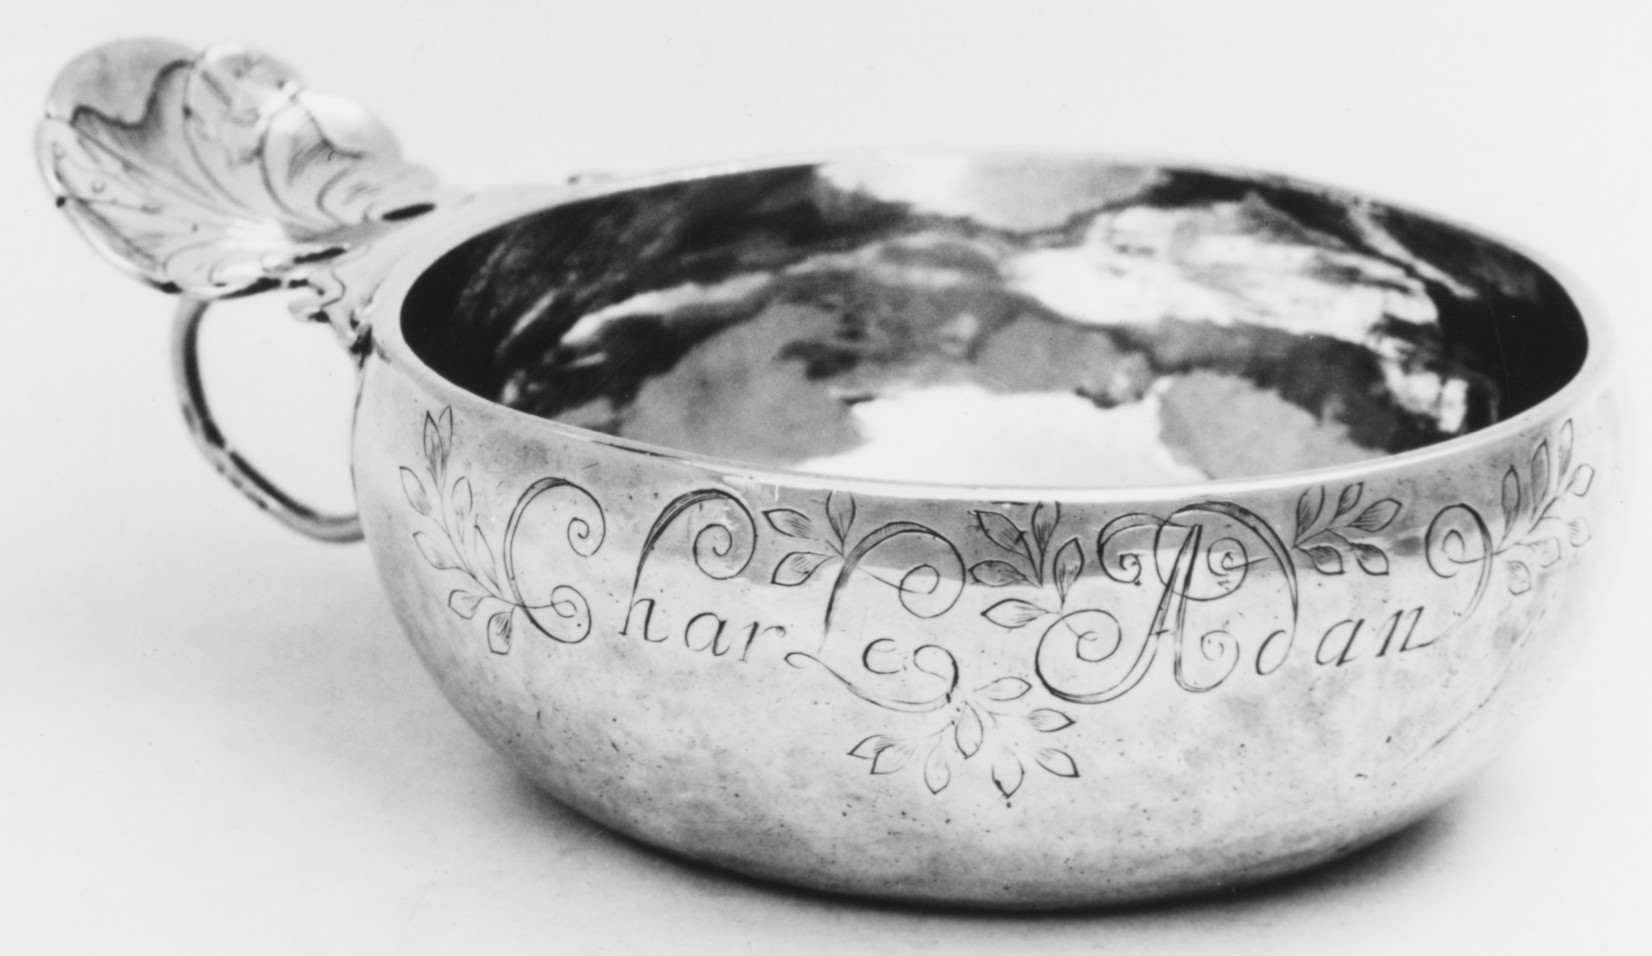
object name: wine taster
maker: d.m.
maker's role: maker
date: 1690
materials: silver